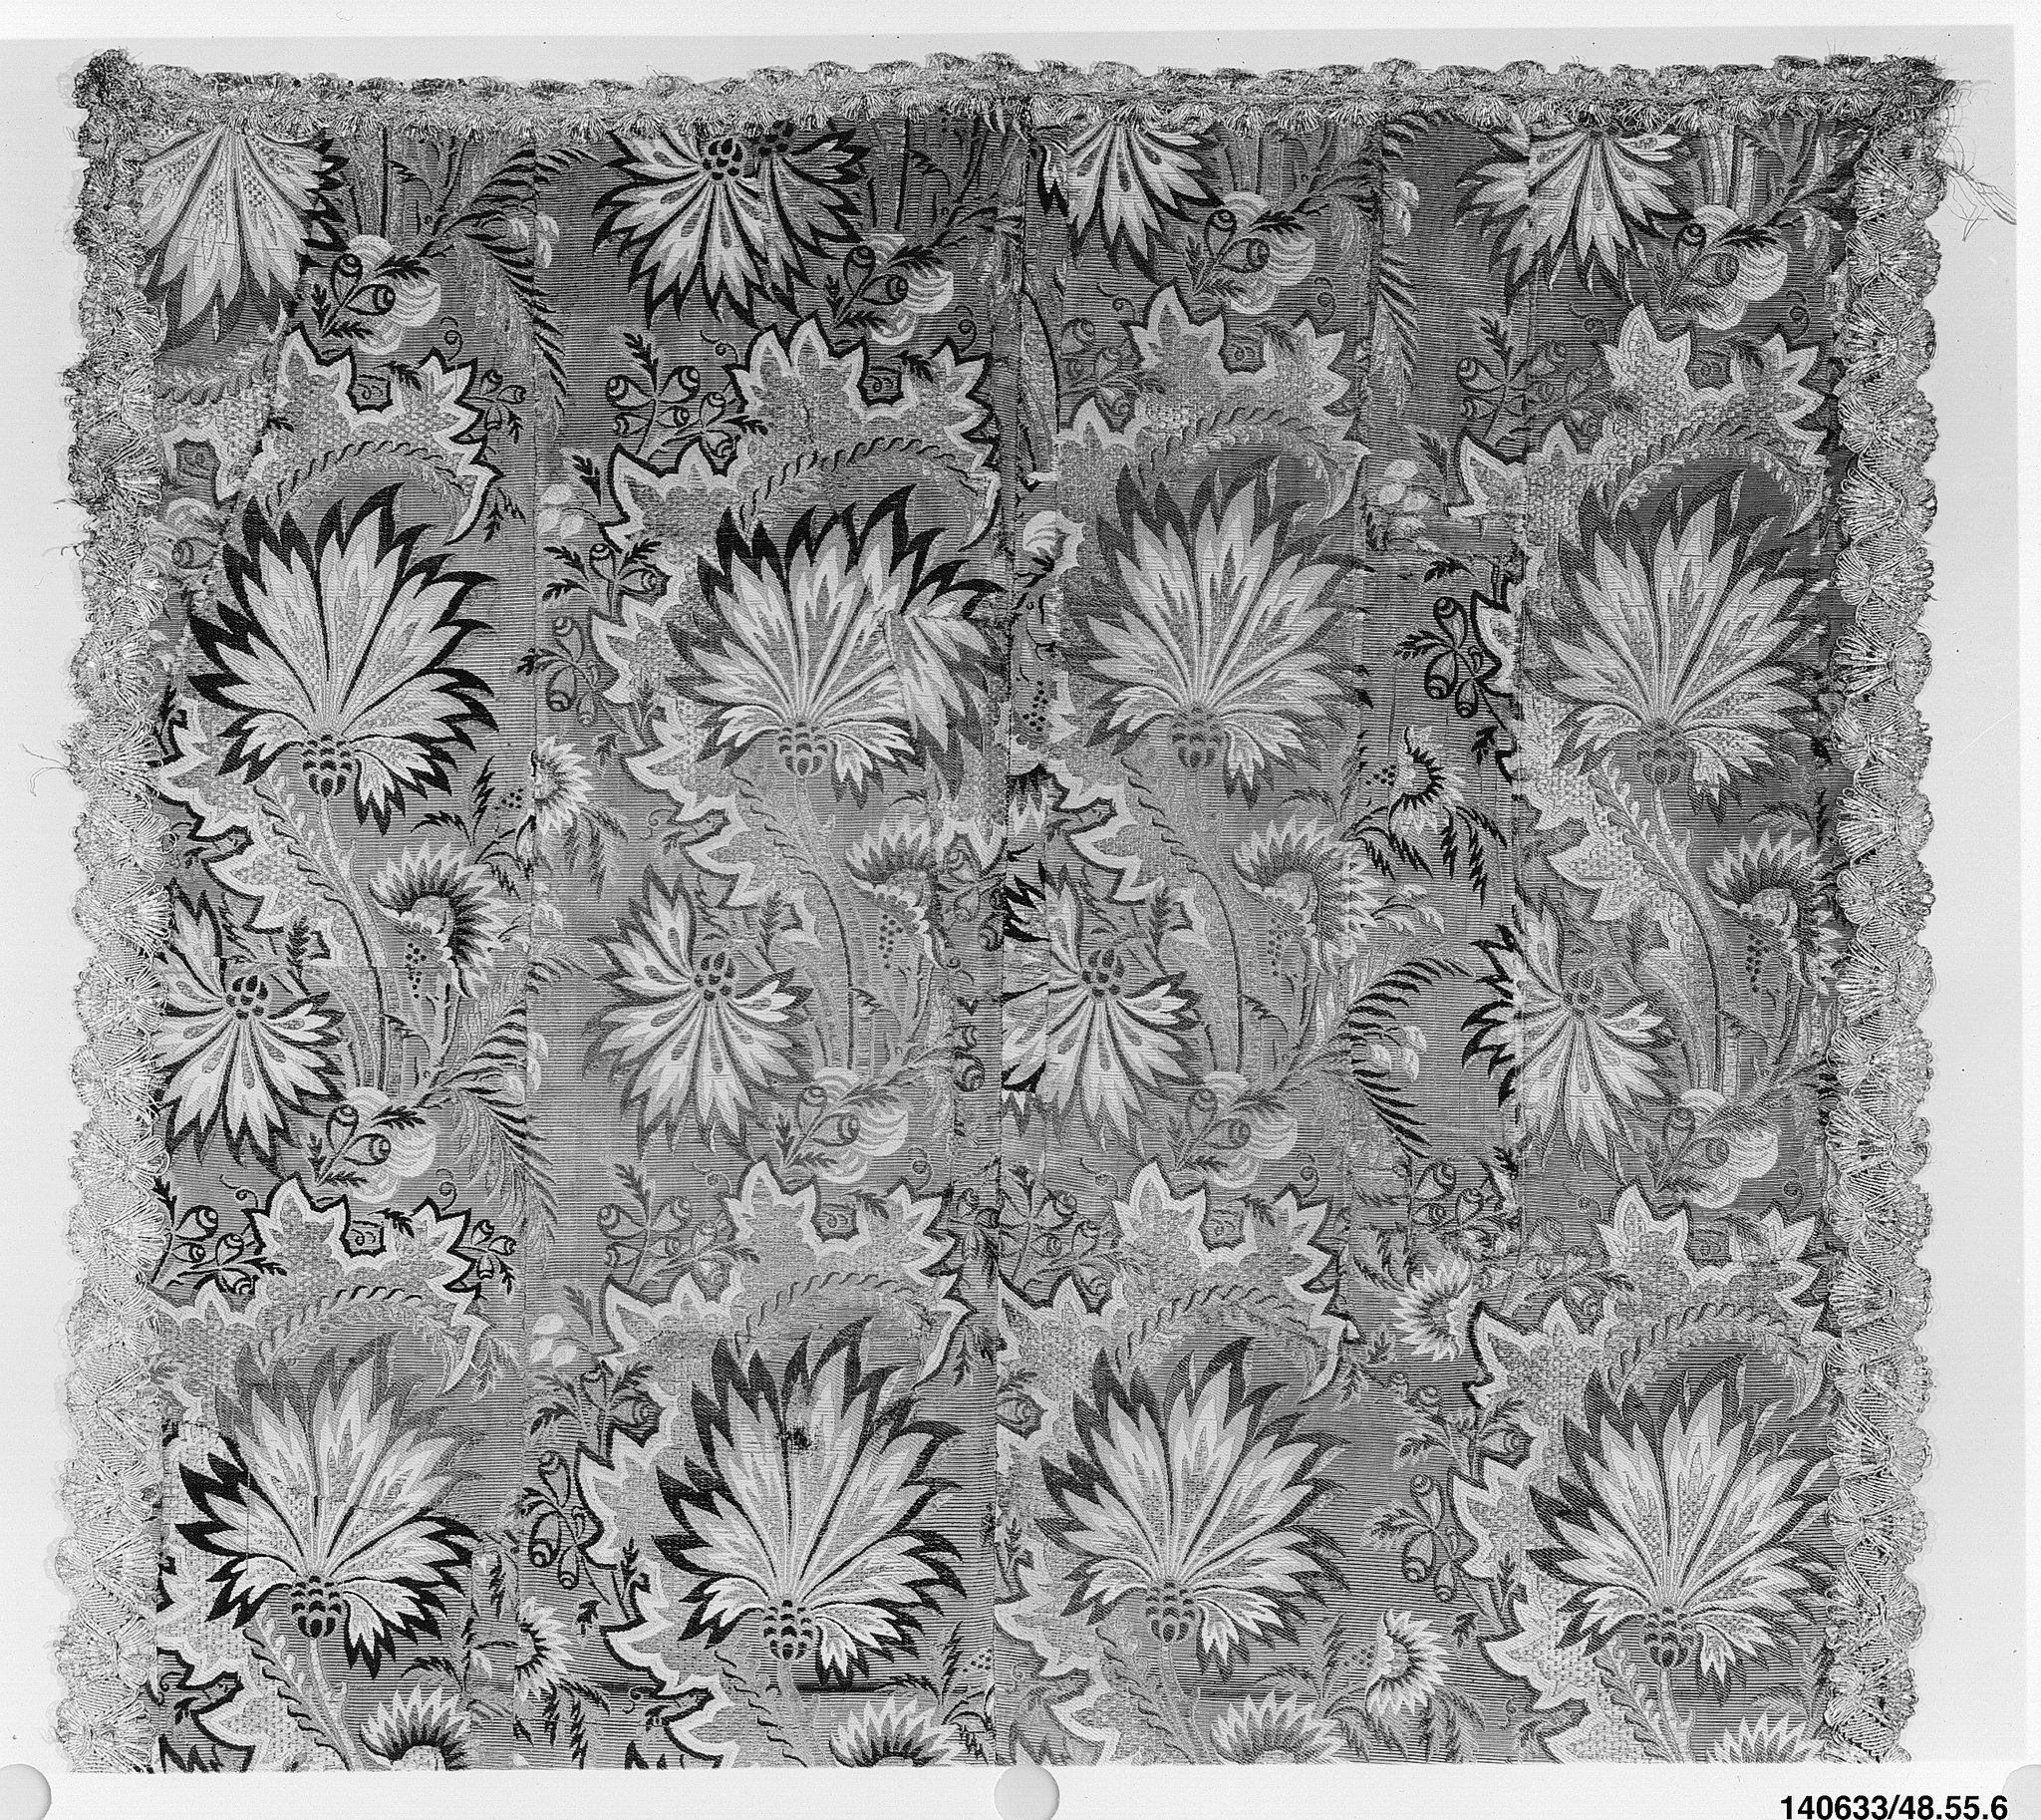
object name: panel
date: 1725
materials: metal thread, silk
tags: flowers